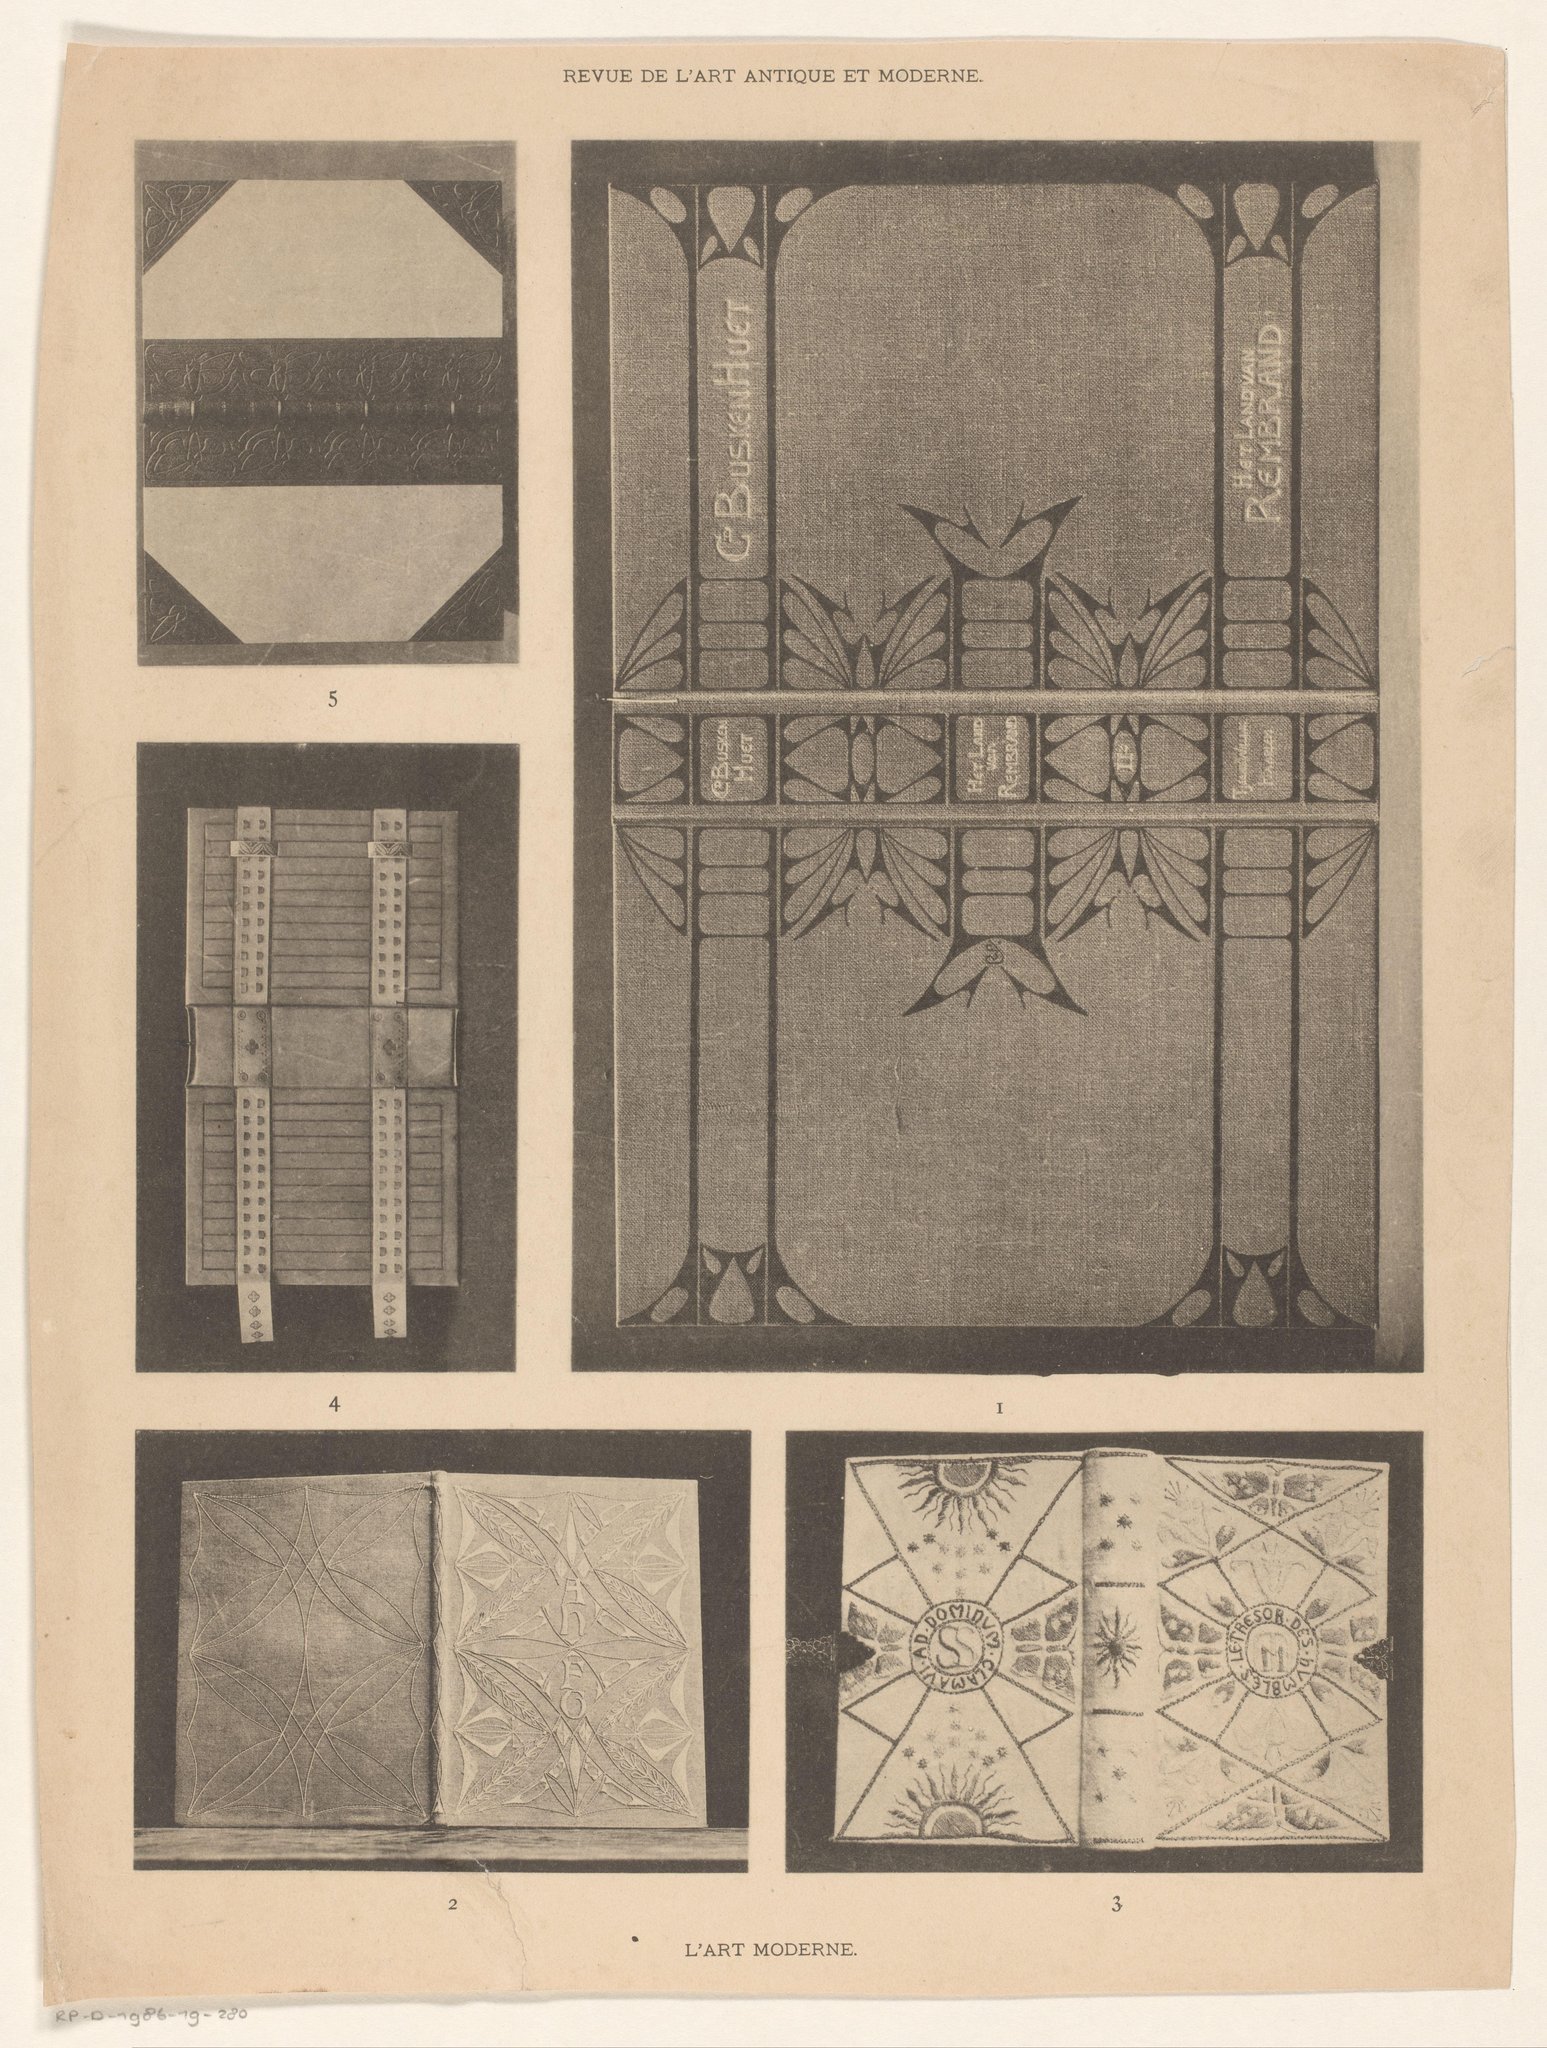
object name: illustration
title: Vijf boekbanden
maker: Anonymous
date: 1885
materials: paper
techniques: photograph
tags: book-cover, binding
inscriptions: collector's mark: ‘R:MVS.’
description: Vijf voorbeelden van boekbanden, waaronder 'Het land van Rembrandt' door Cd. Busken-Huet en 'Le trésor des humbles' door Maurice Maeterlinck.